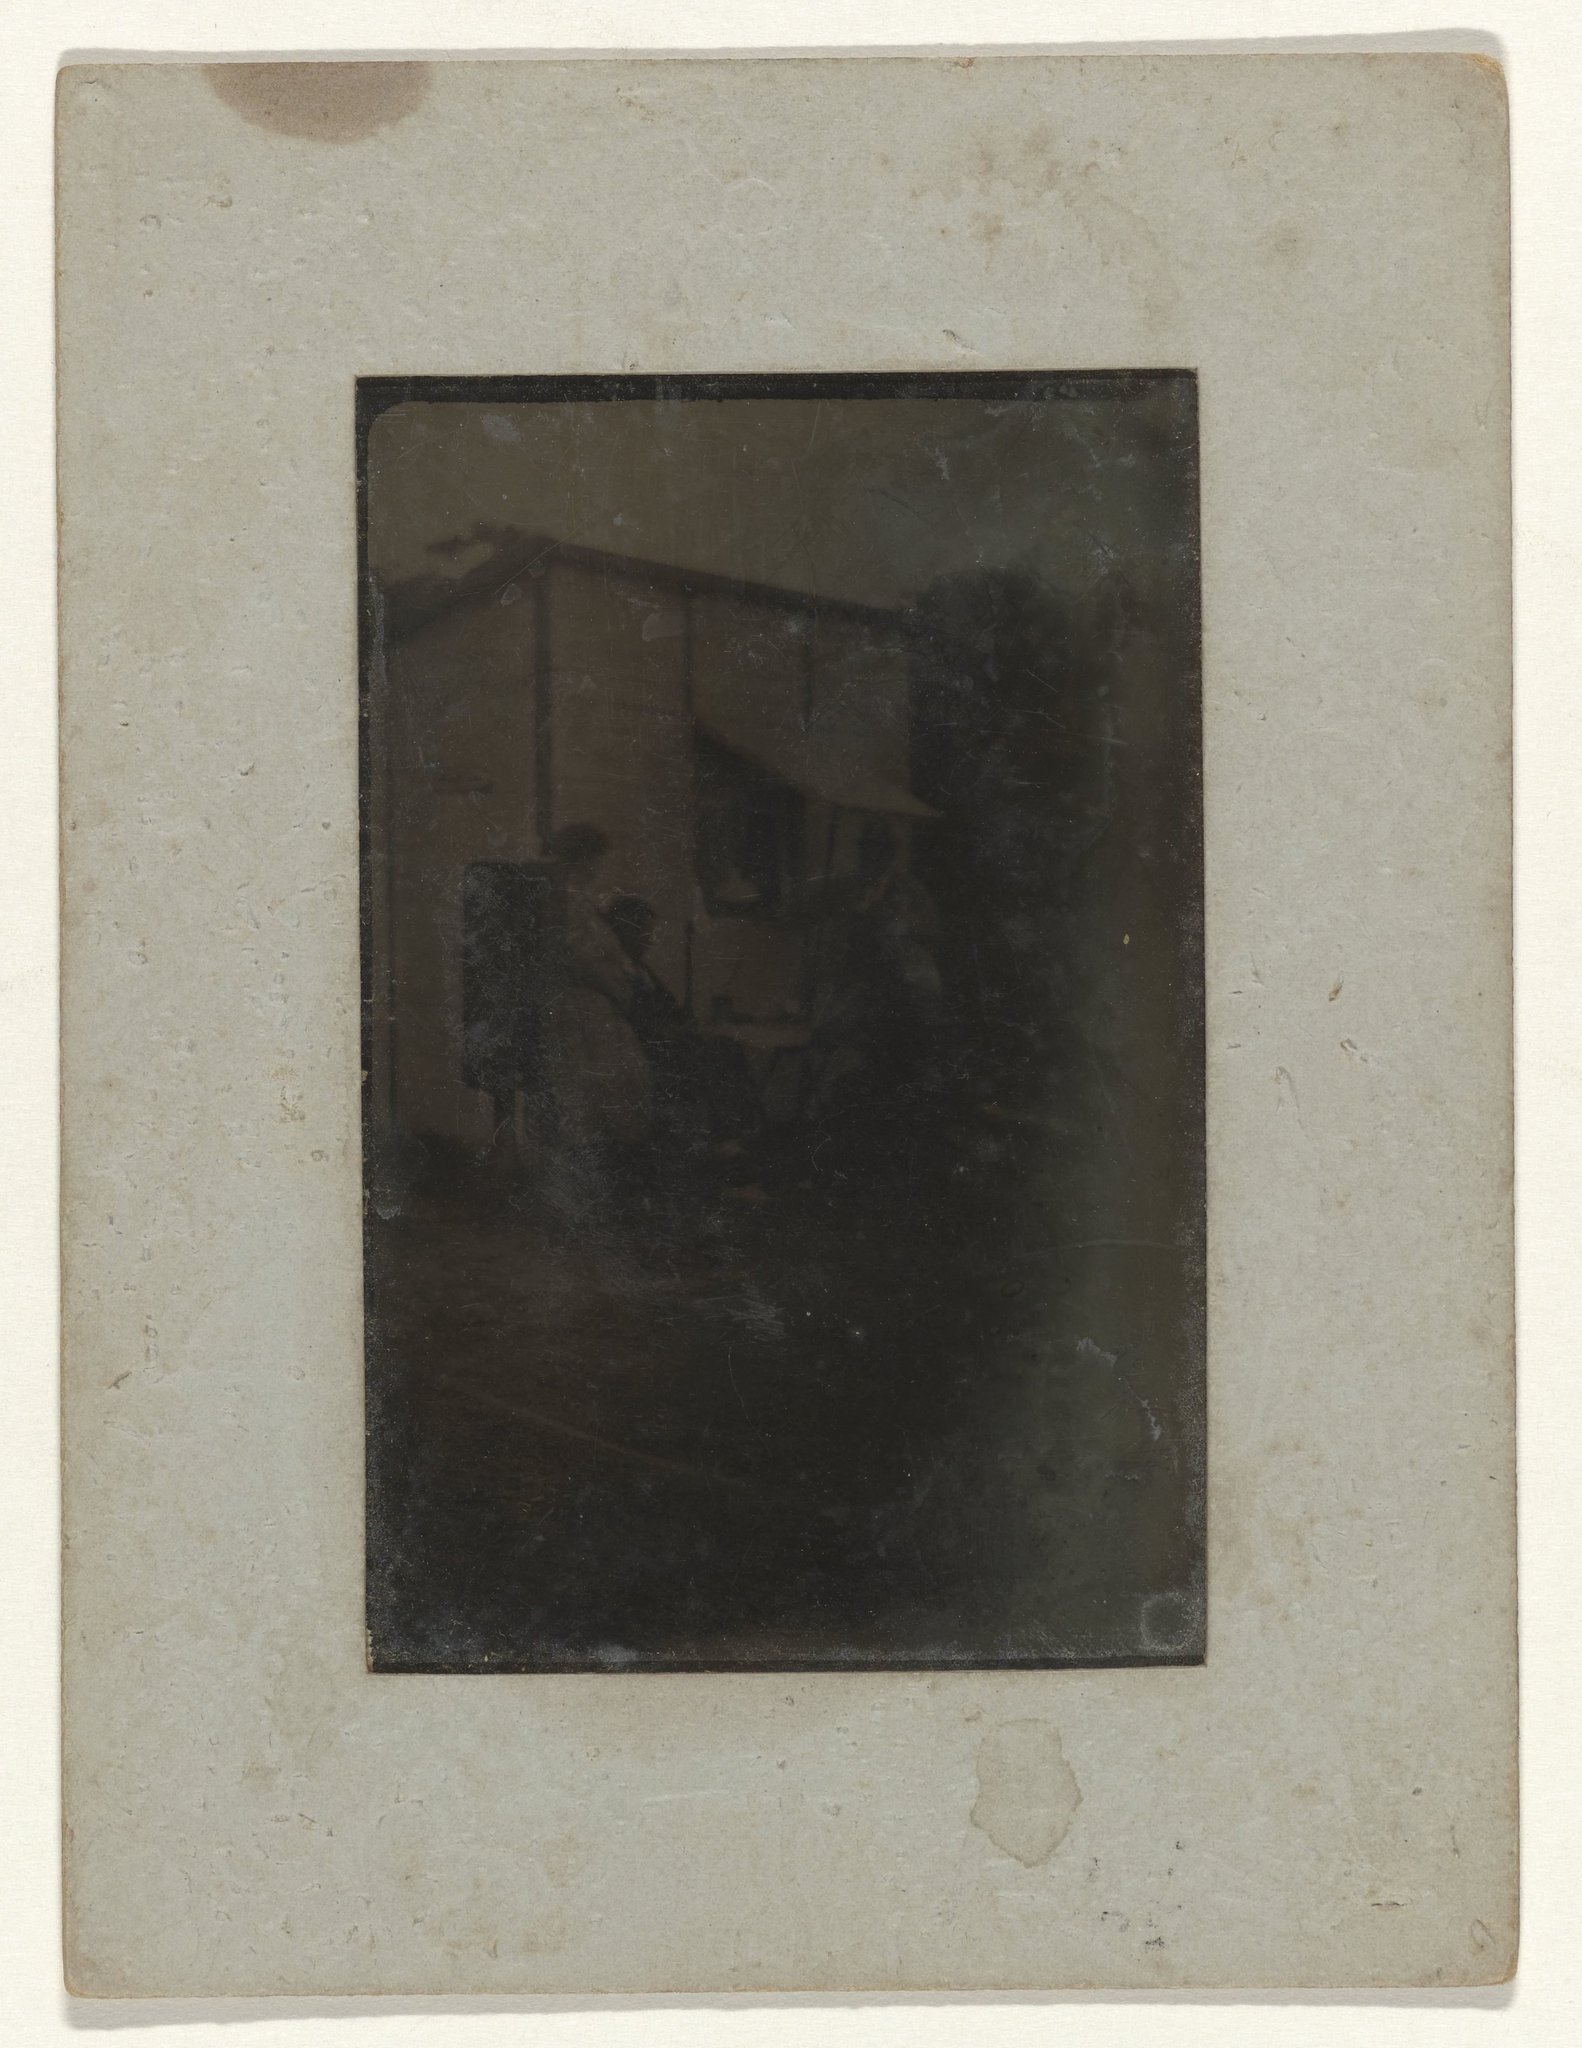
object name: photograph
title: Groepsportret van vier onbekende mensen voor een strandhuis bij Valkeveen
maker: Anonymous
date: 1915-1925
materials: cardboard, iron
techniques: ferrotyping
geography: valkeveen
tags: beach (as place of recreation), historical persons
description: Groepsportret van vier mensen die voor een strandhuisje (bij Valkeveen?) staan en zitten.